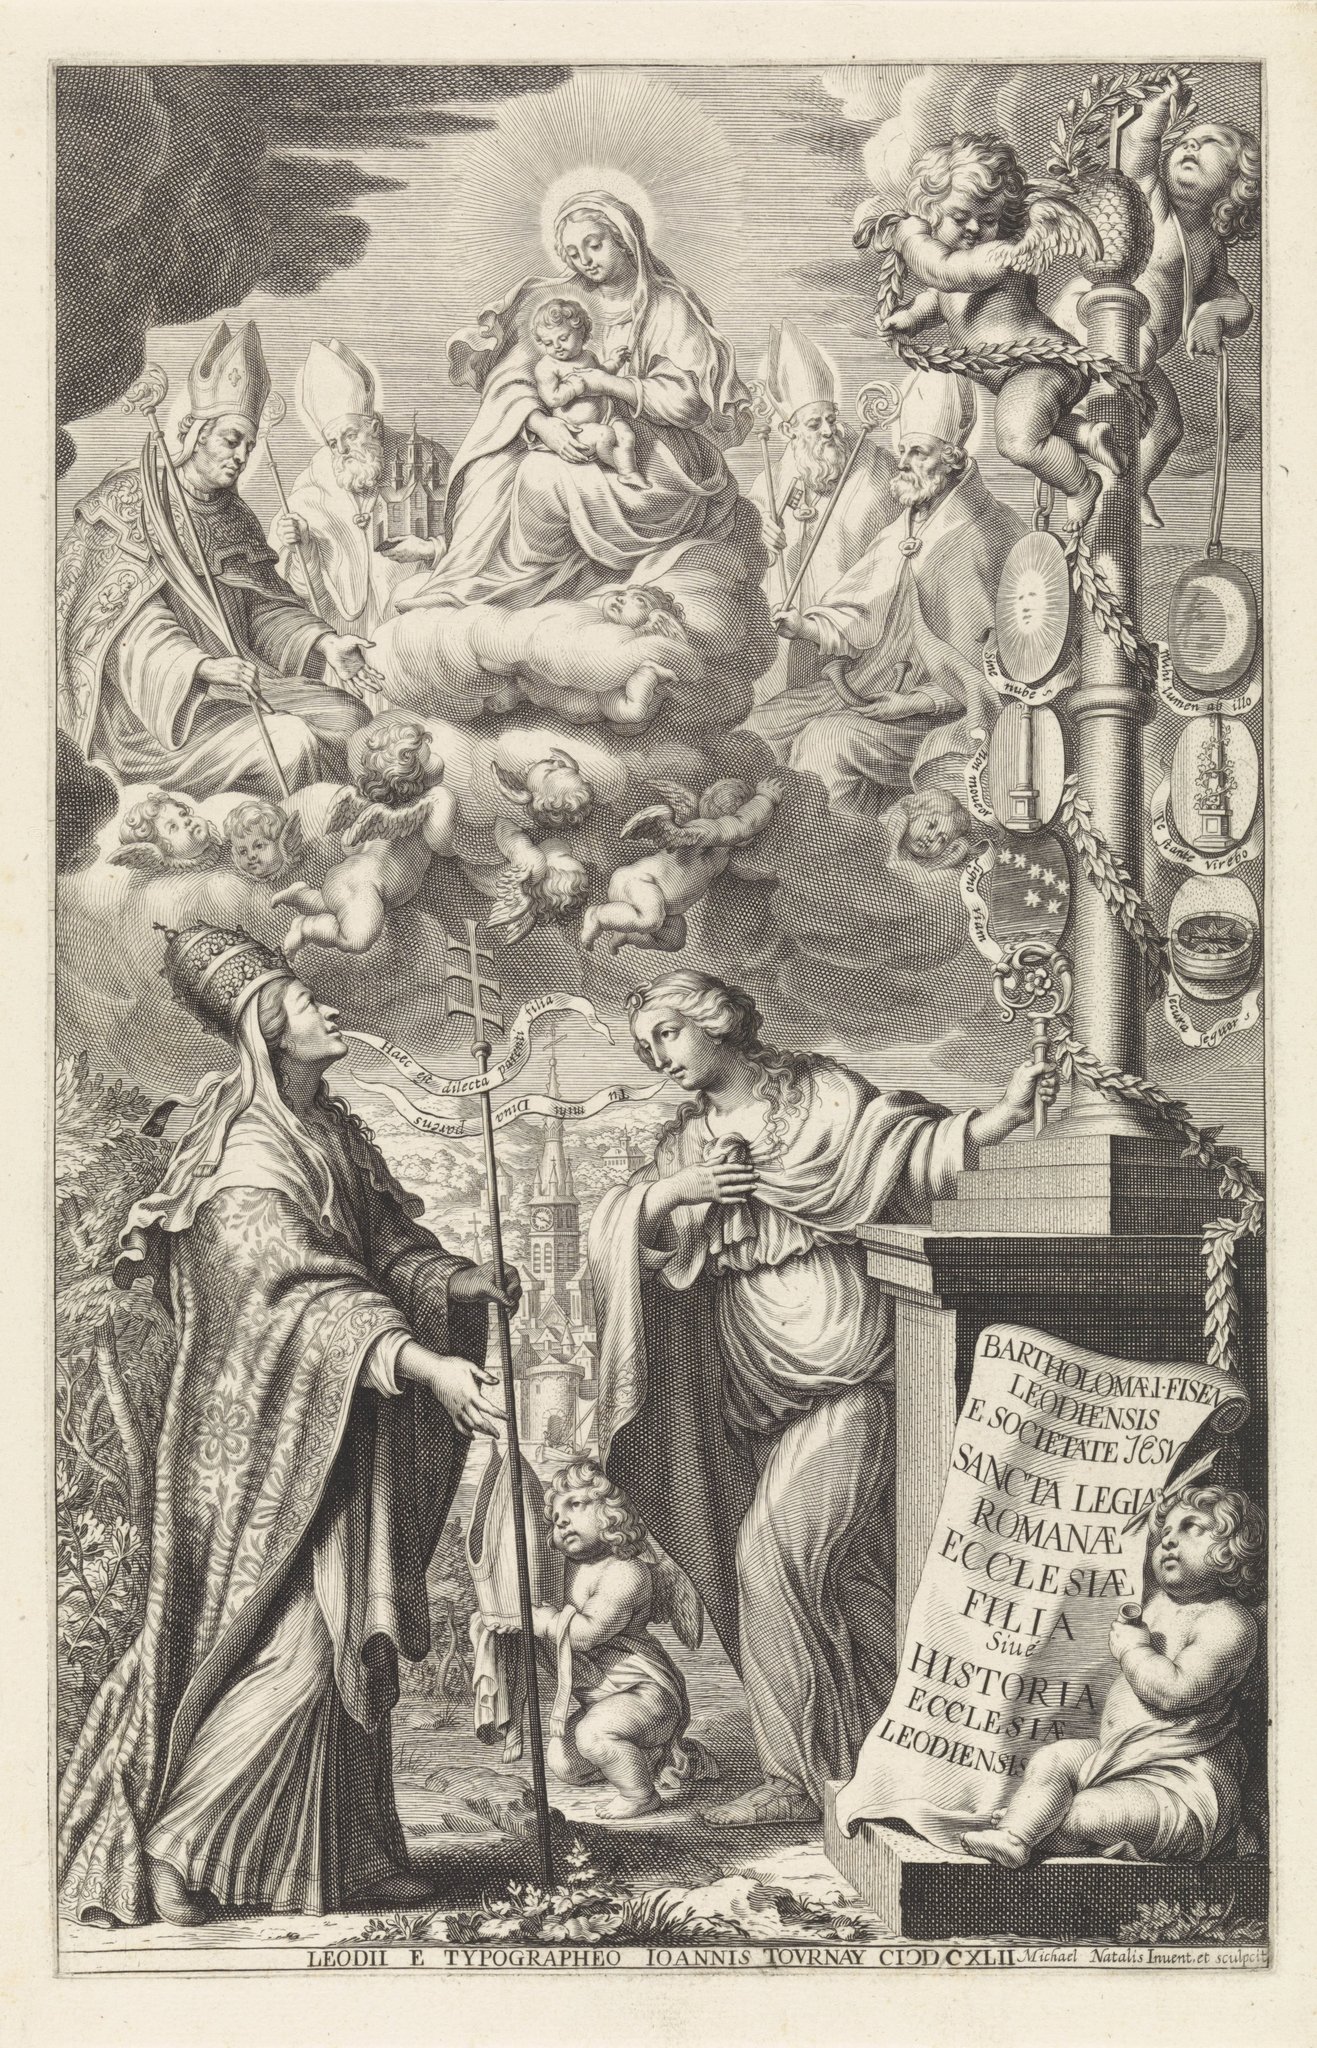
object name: print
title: Titelpagina voor: Bartholomaei Fisen, Leodiensis e Societate Jesu ((...)), 1642.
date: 1642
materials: paper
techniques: engraving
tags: madonna: mary sitting or enthroned, the christ-child in her lap (or in front of her bosom) (mary sometimes represented half-length), archbishop, bishop, etc. (roman catholic), the church personified, 'ecclesia', usually with chalice and banner, cities represented allegorically or symbolically, liège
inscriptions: collector's mark: Lugt 2228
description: De personificatie van de Kerk, een vrouwfiguur met pauselijke tiara en staf, kijkt omhoog. Op de wolken zitten Maria met Kind, te midden van vier bisschoppen van Luik: Maternus, Servaas van Maastricht, Lambertus van Maastricht en Hubertus. Tegenover de personificatie van de Kerk staat de personificatie van de stad Luik, een vrouw met in de hand een staf. Voor haar knielt een putto met een mijter in de handen voor de Kerk. Rechts een standbeeld, waaraan zes schilden hangen. Op de achtergrond in het landschap de stad Luik.